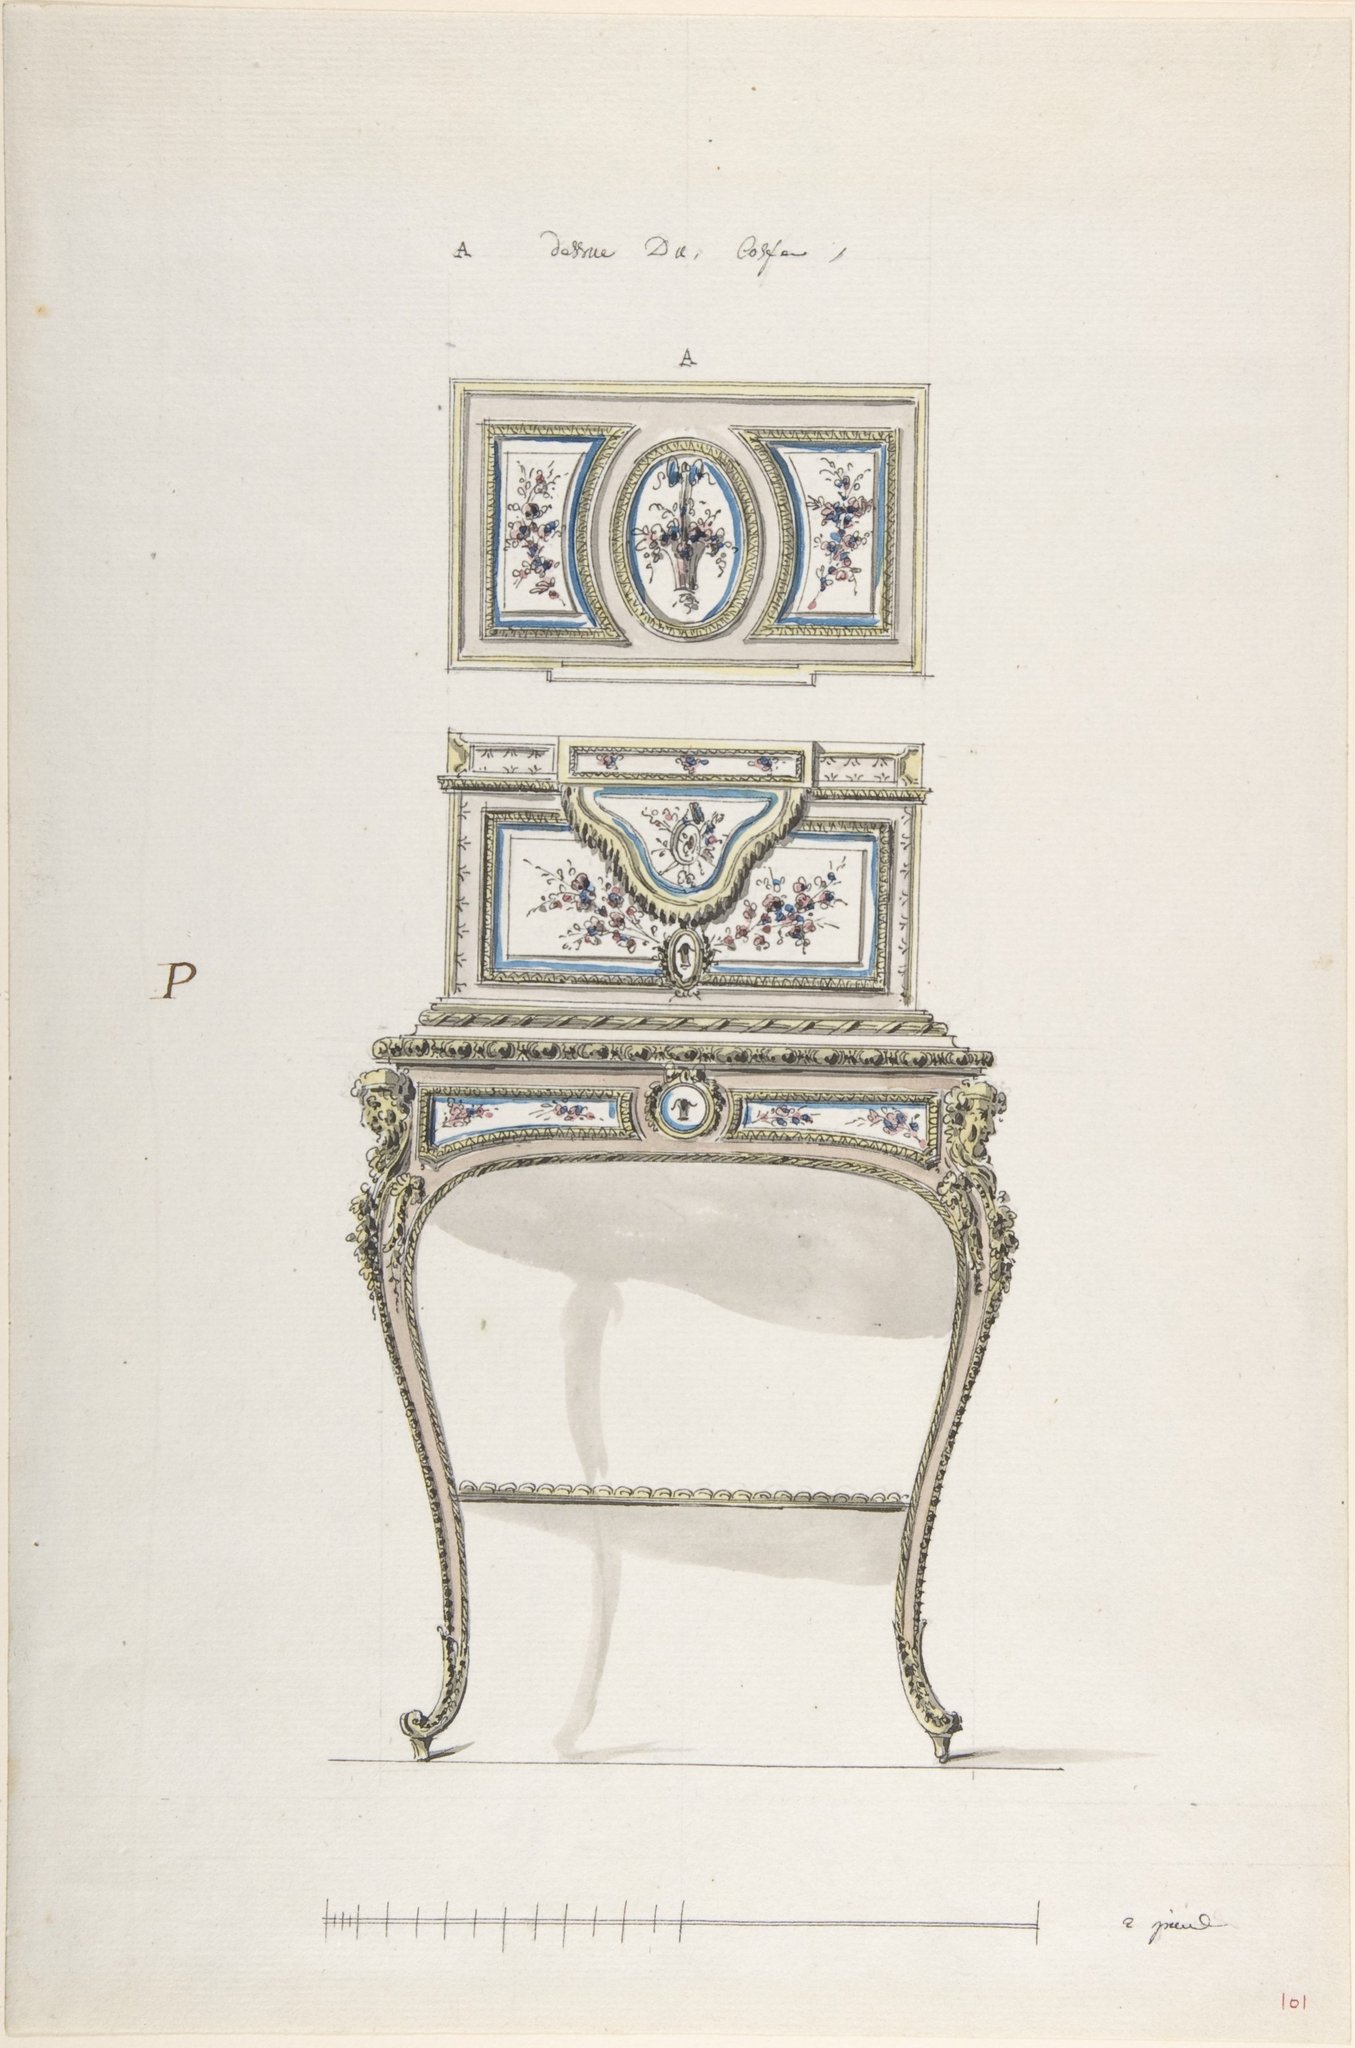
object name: drawing ornament architecture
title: Design for a Jewel Coffer on a Writing Stand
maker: anonymous, french, 18th century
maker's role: artist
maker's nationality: french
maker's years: 1700-1800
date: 1770-1775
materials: graphite, ink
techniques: brush, pen, drawing, wash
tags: flowers,furniture